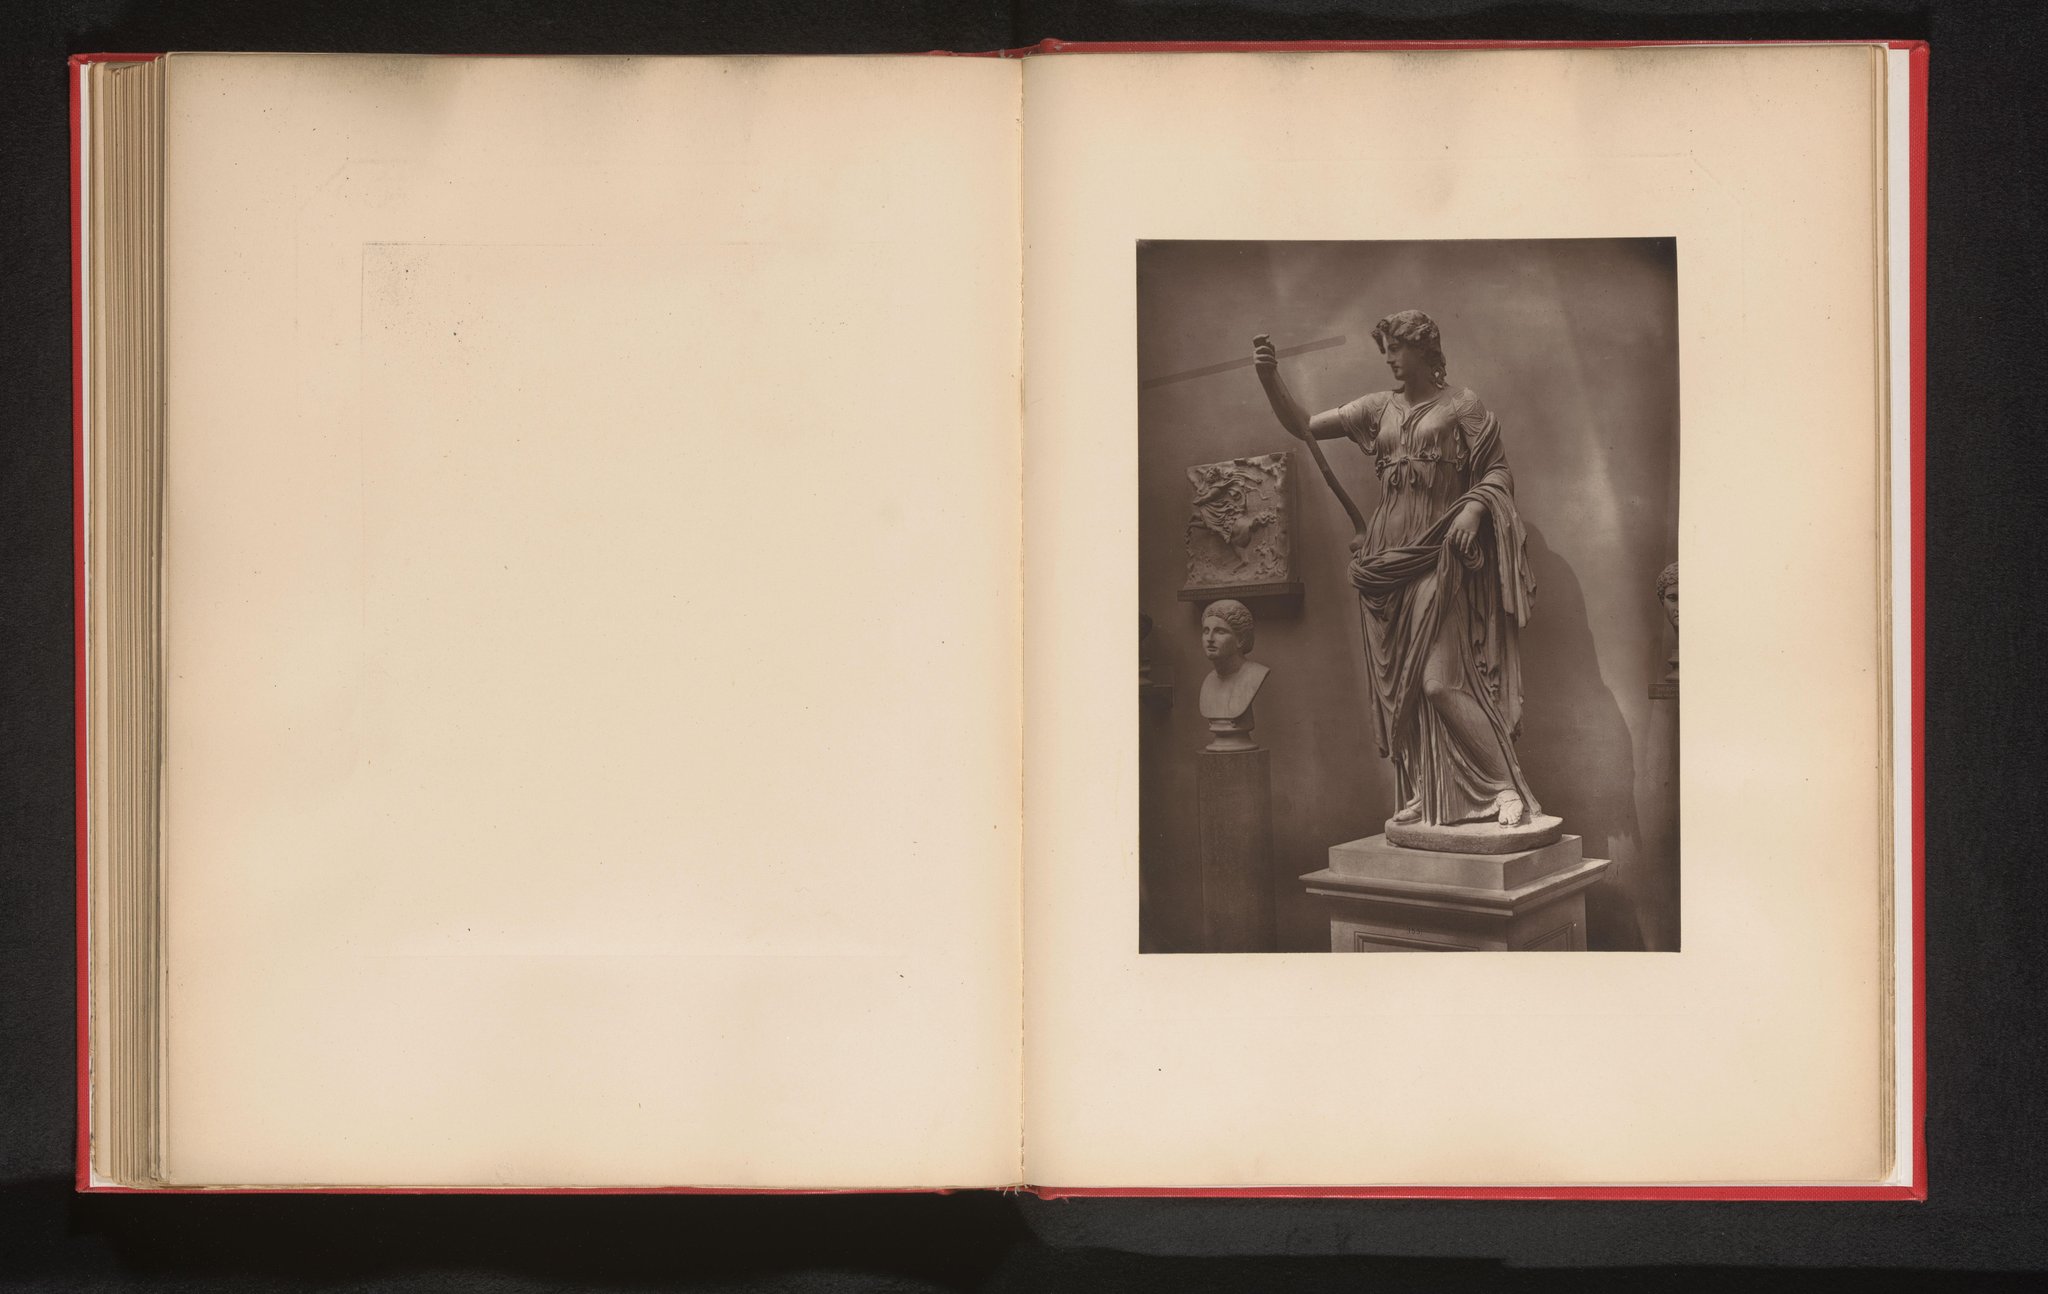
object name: photomechanical print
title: Standbeeld van de muze Thalia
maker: stephen thompson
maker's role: fotograaf, schrijver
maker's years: 1831-1893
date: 1873-1878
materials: paper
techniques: woodburytype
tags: sculpture, thalia (one of the muses); 'talia' (ripa)